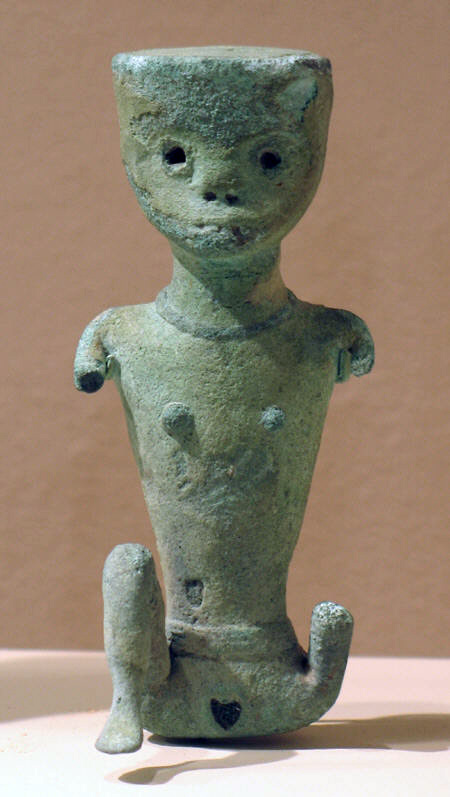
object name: figure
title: Seated Female Figure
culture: indonesian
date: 500 BCE-300 CE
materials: bronze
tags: women